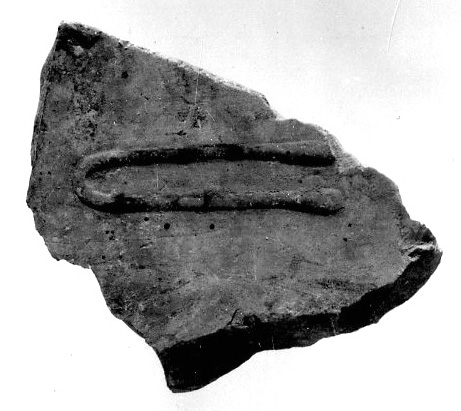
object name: relief fragment, tomb of meketre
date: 1981-1975 BCE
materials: limestone, paint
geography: egypt